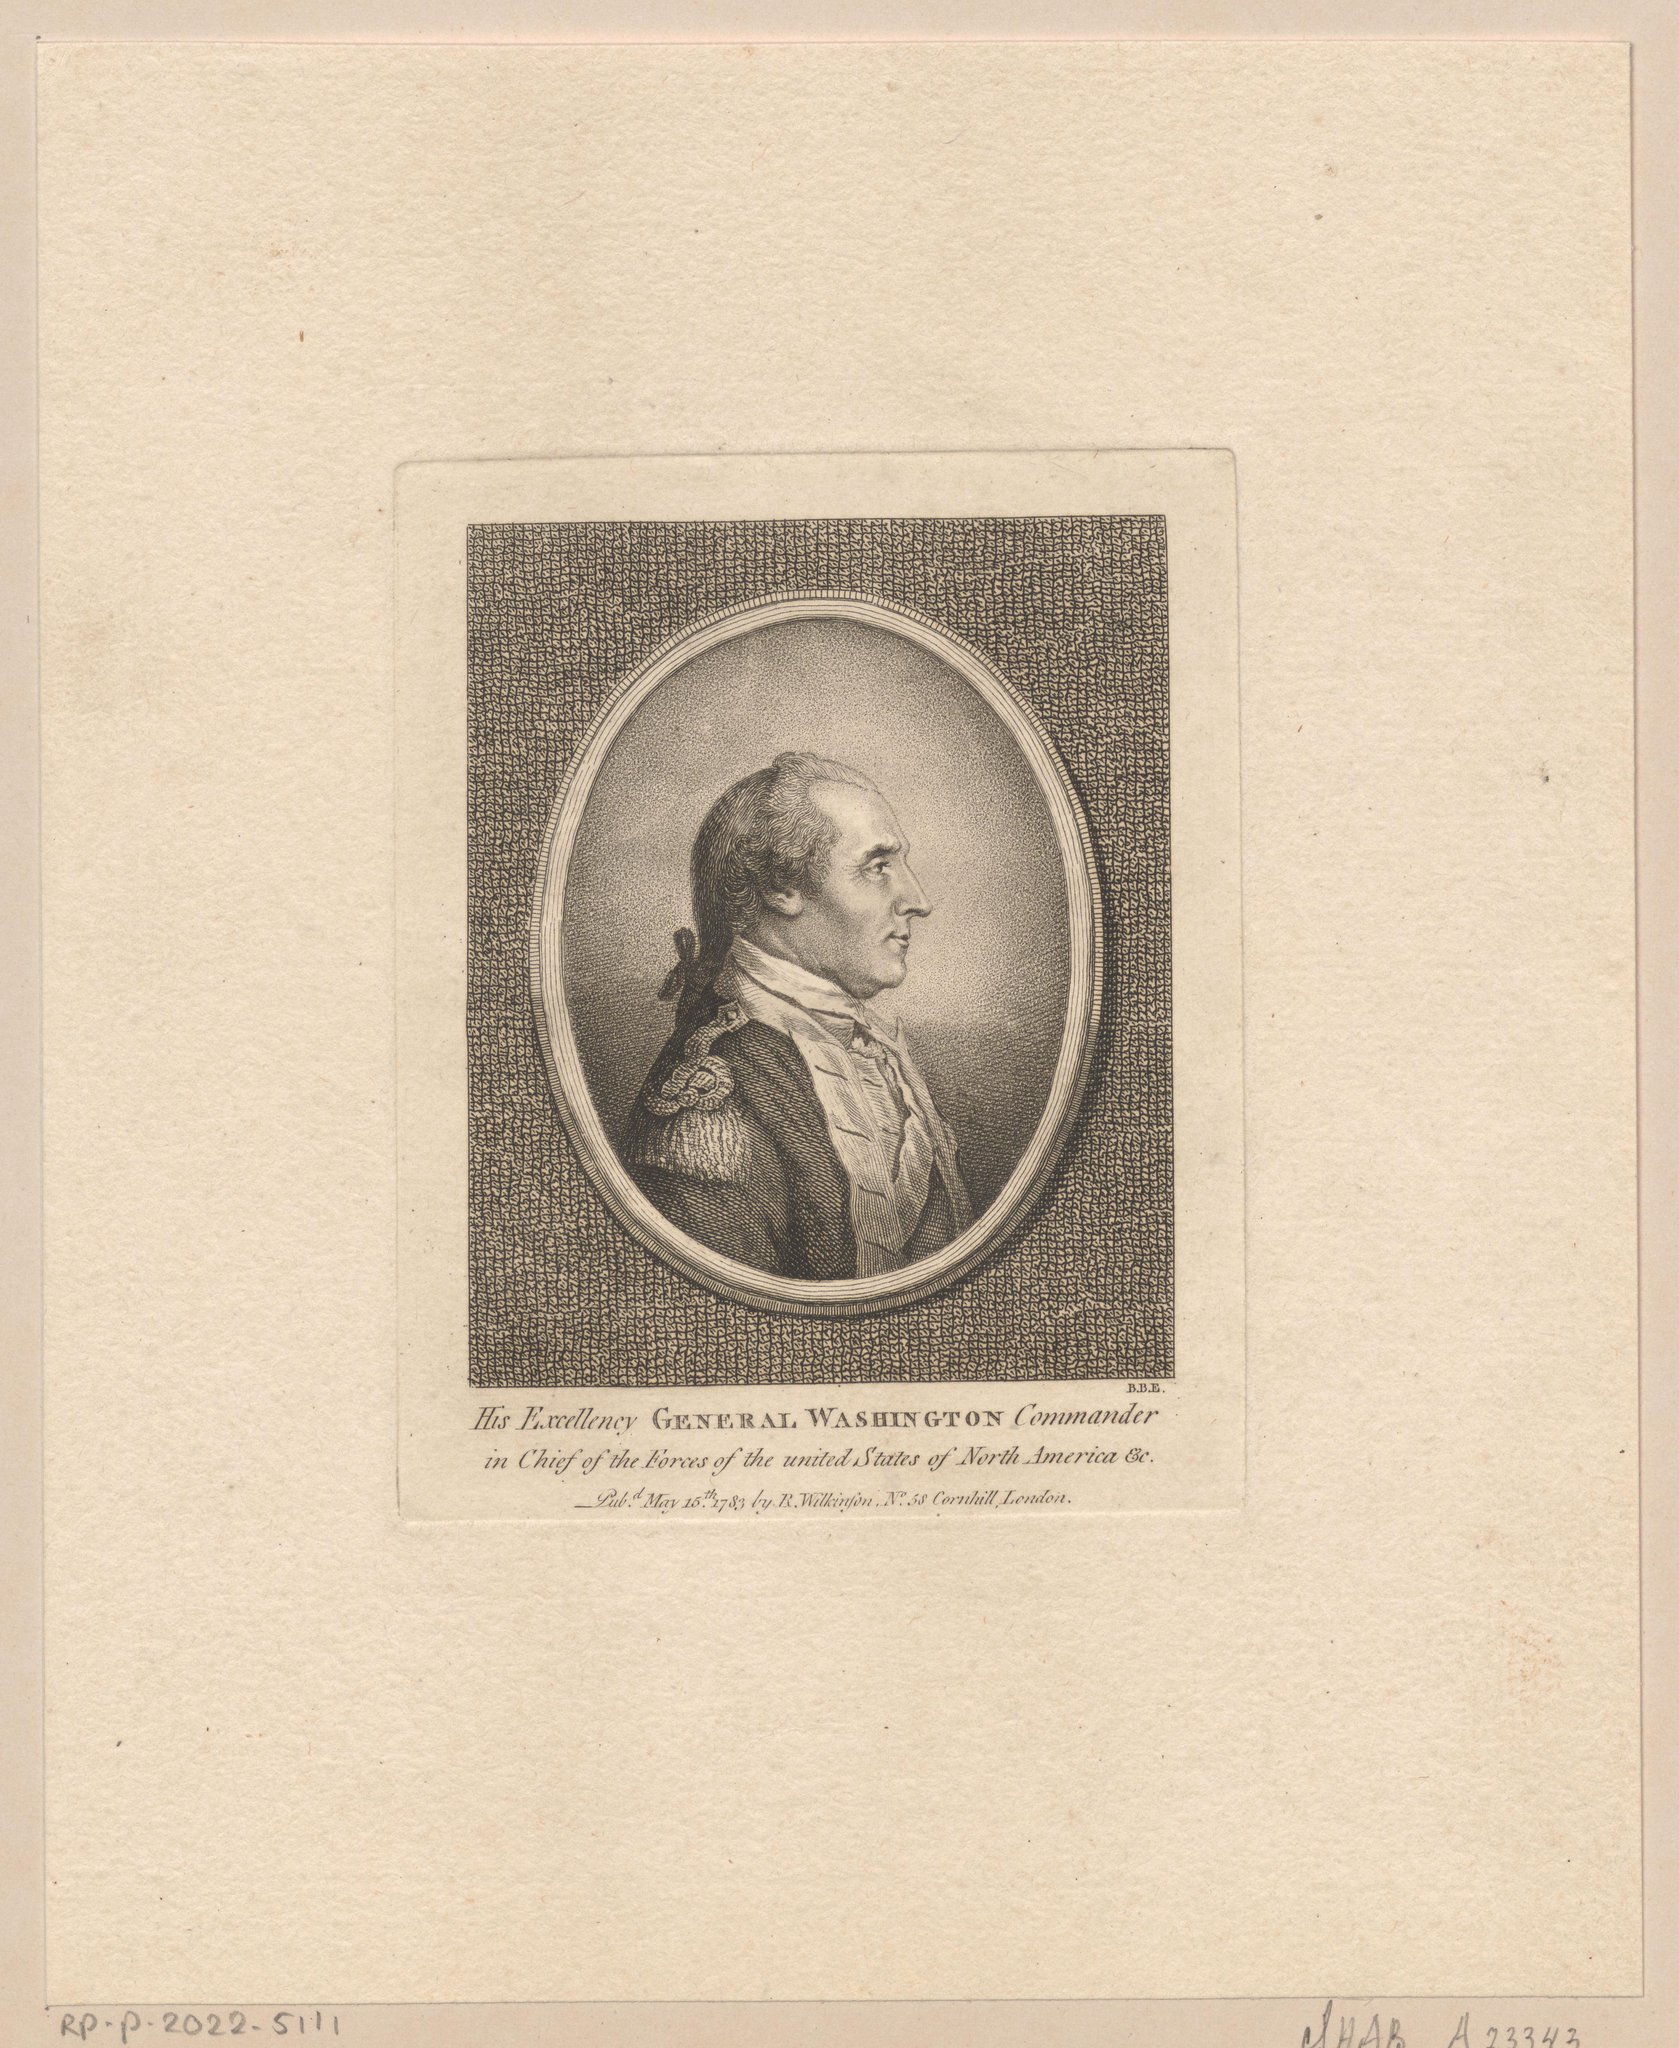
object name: print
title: Portret van George Washington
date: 1783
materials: paper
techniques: etching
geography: london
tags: president ~ head of republic, historical persons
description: Met een drieregelig onderschrift in het Engels.